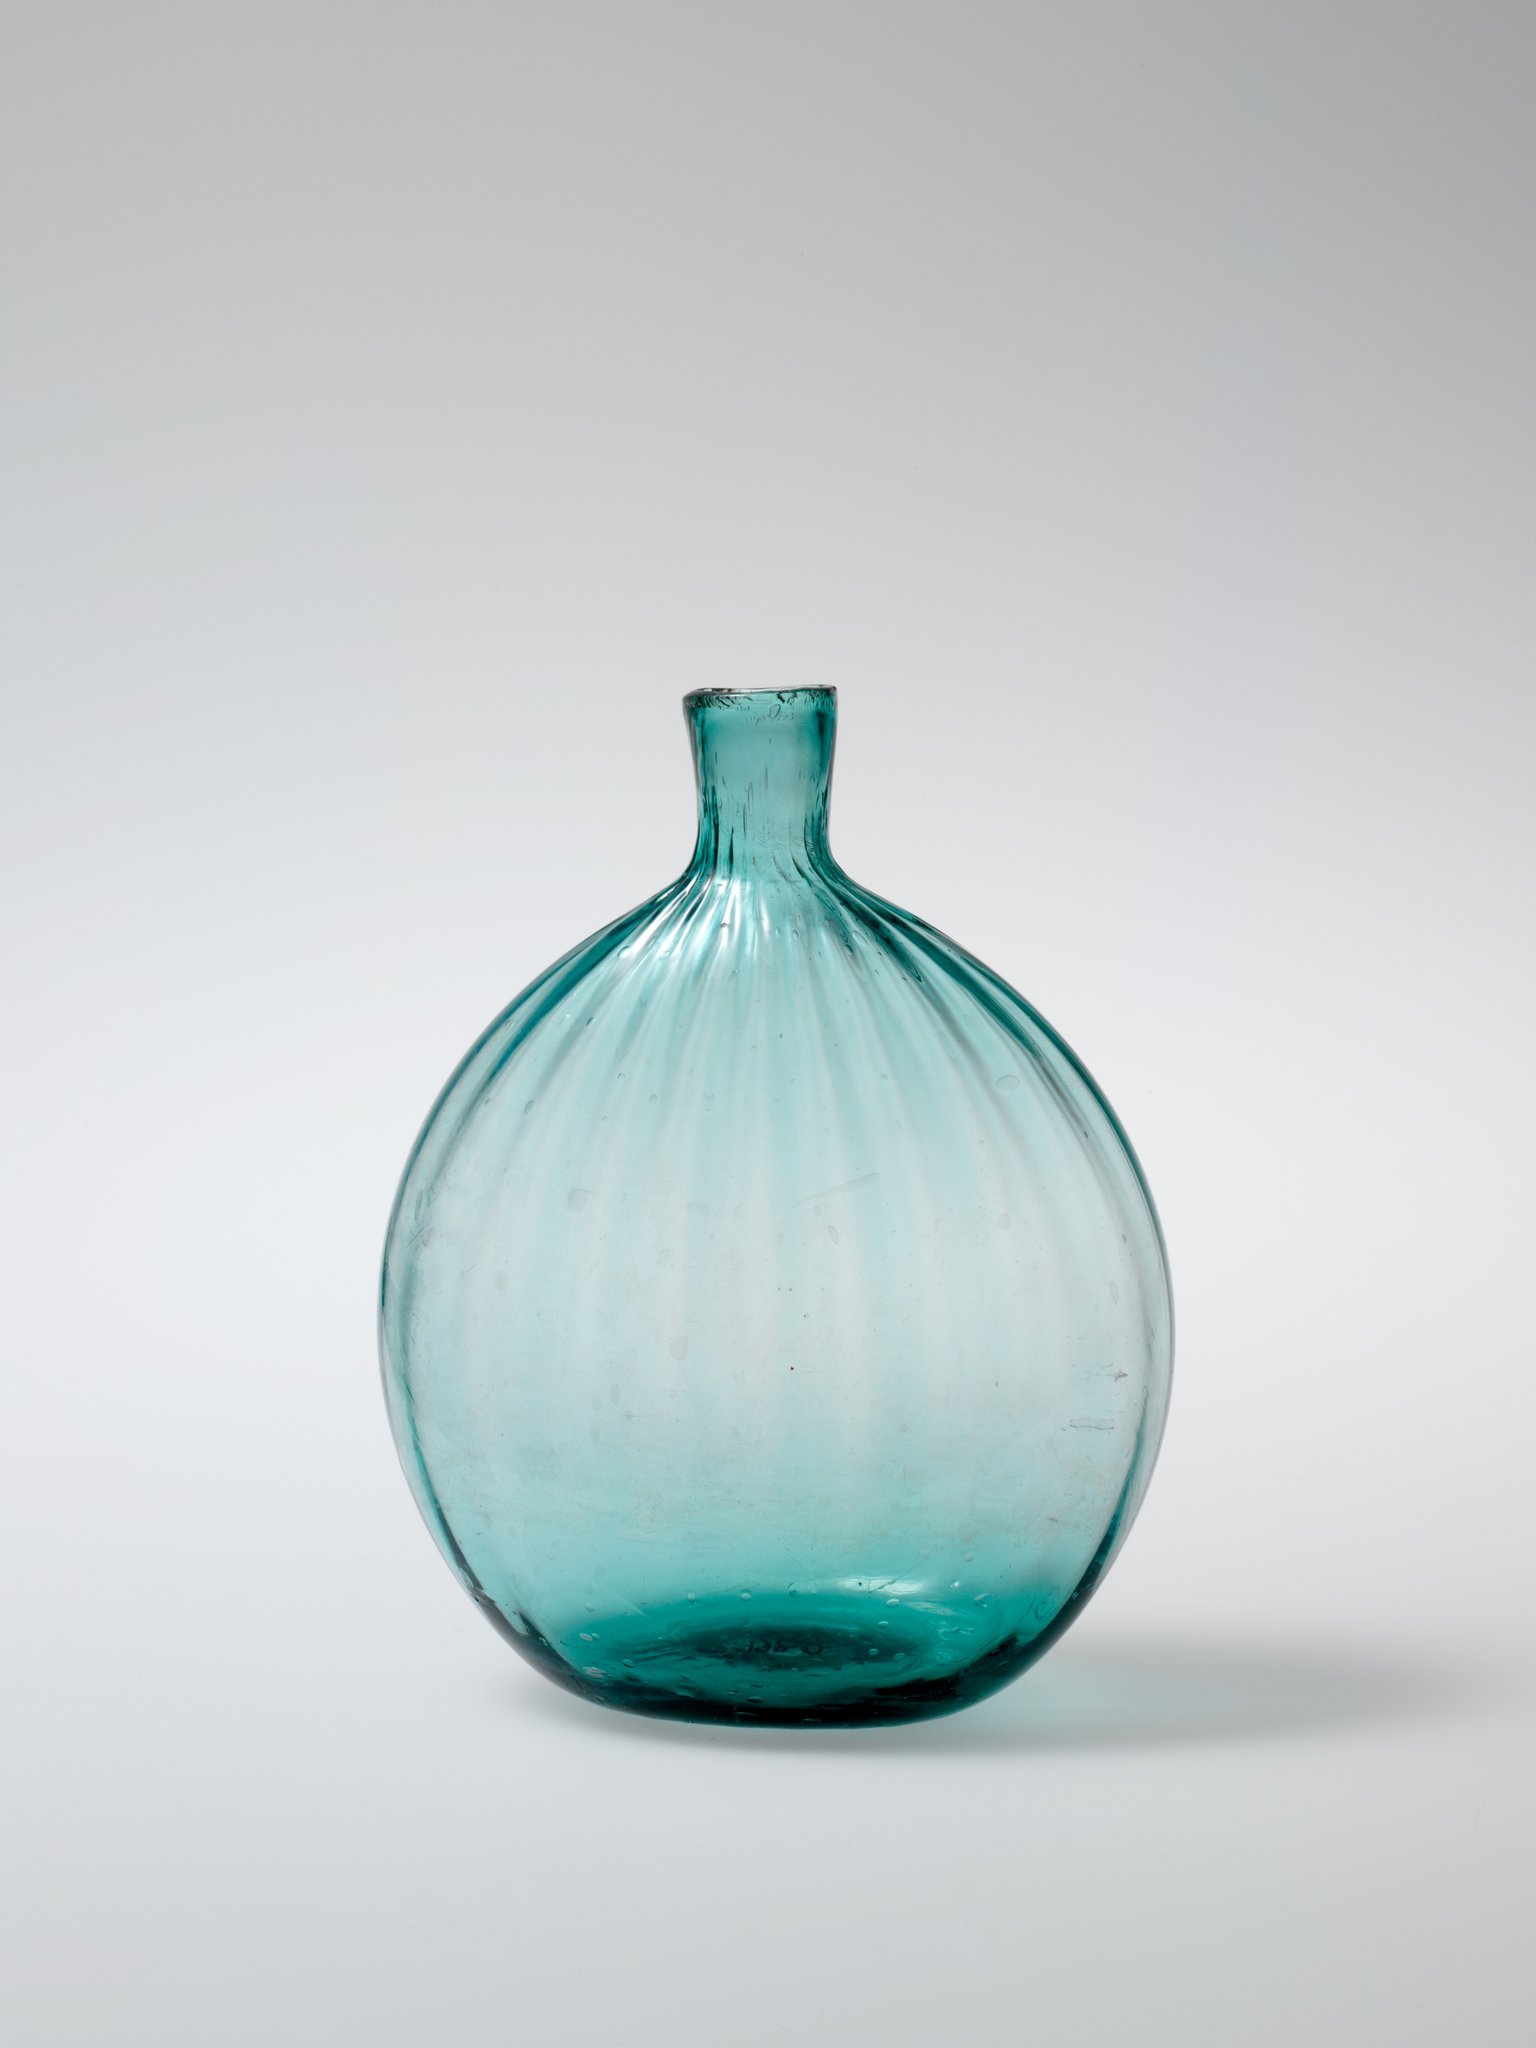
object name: pocket bottle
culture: american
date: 1815-1840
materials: glass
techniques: glassblowing, molding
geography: united states